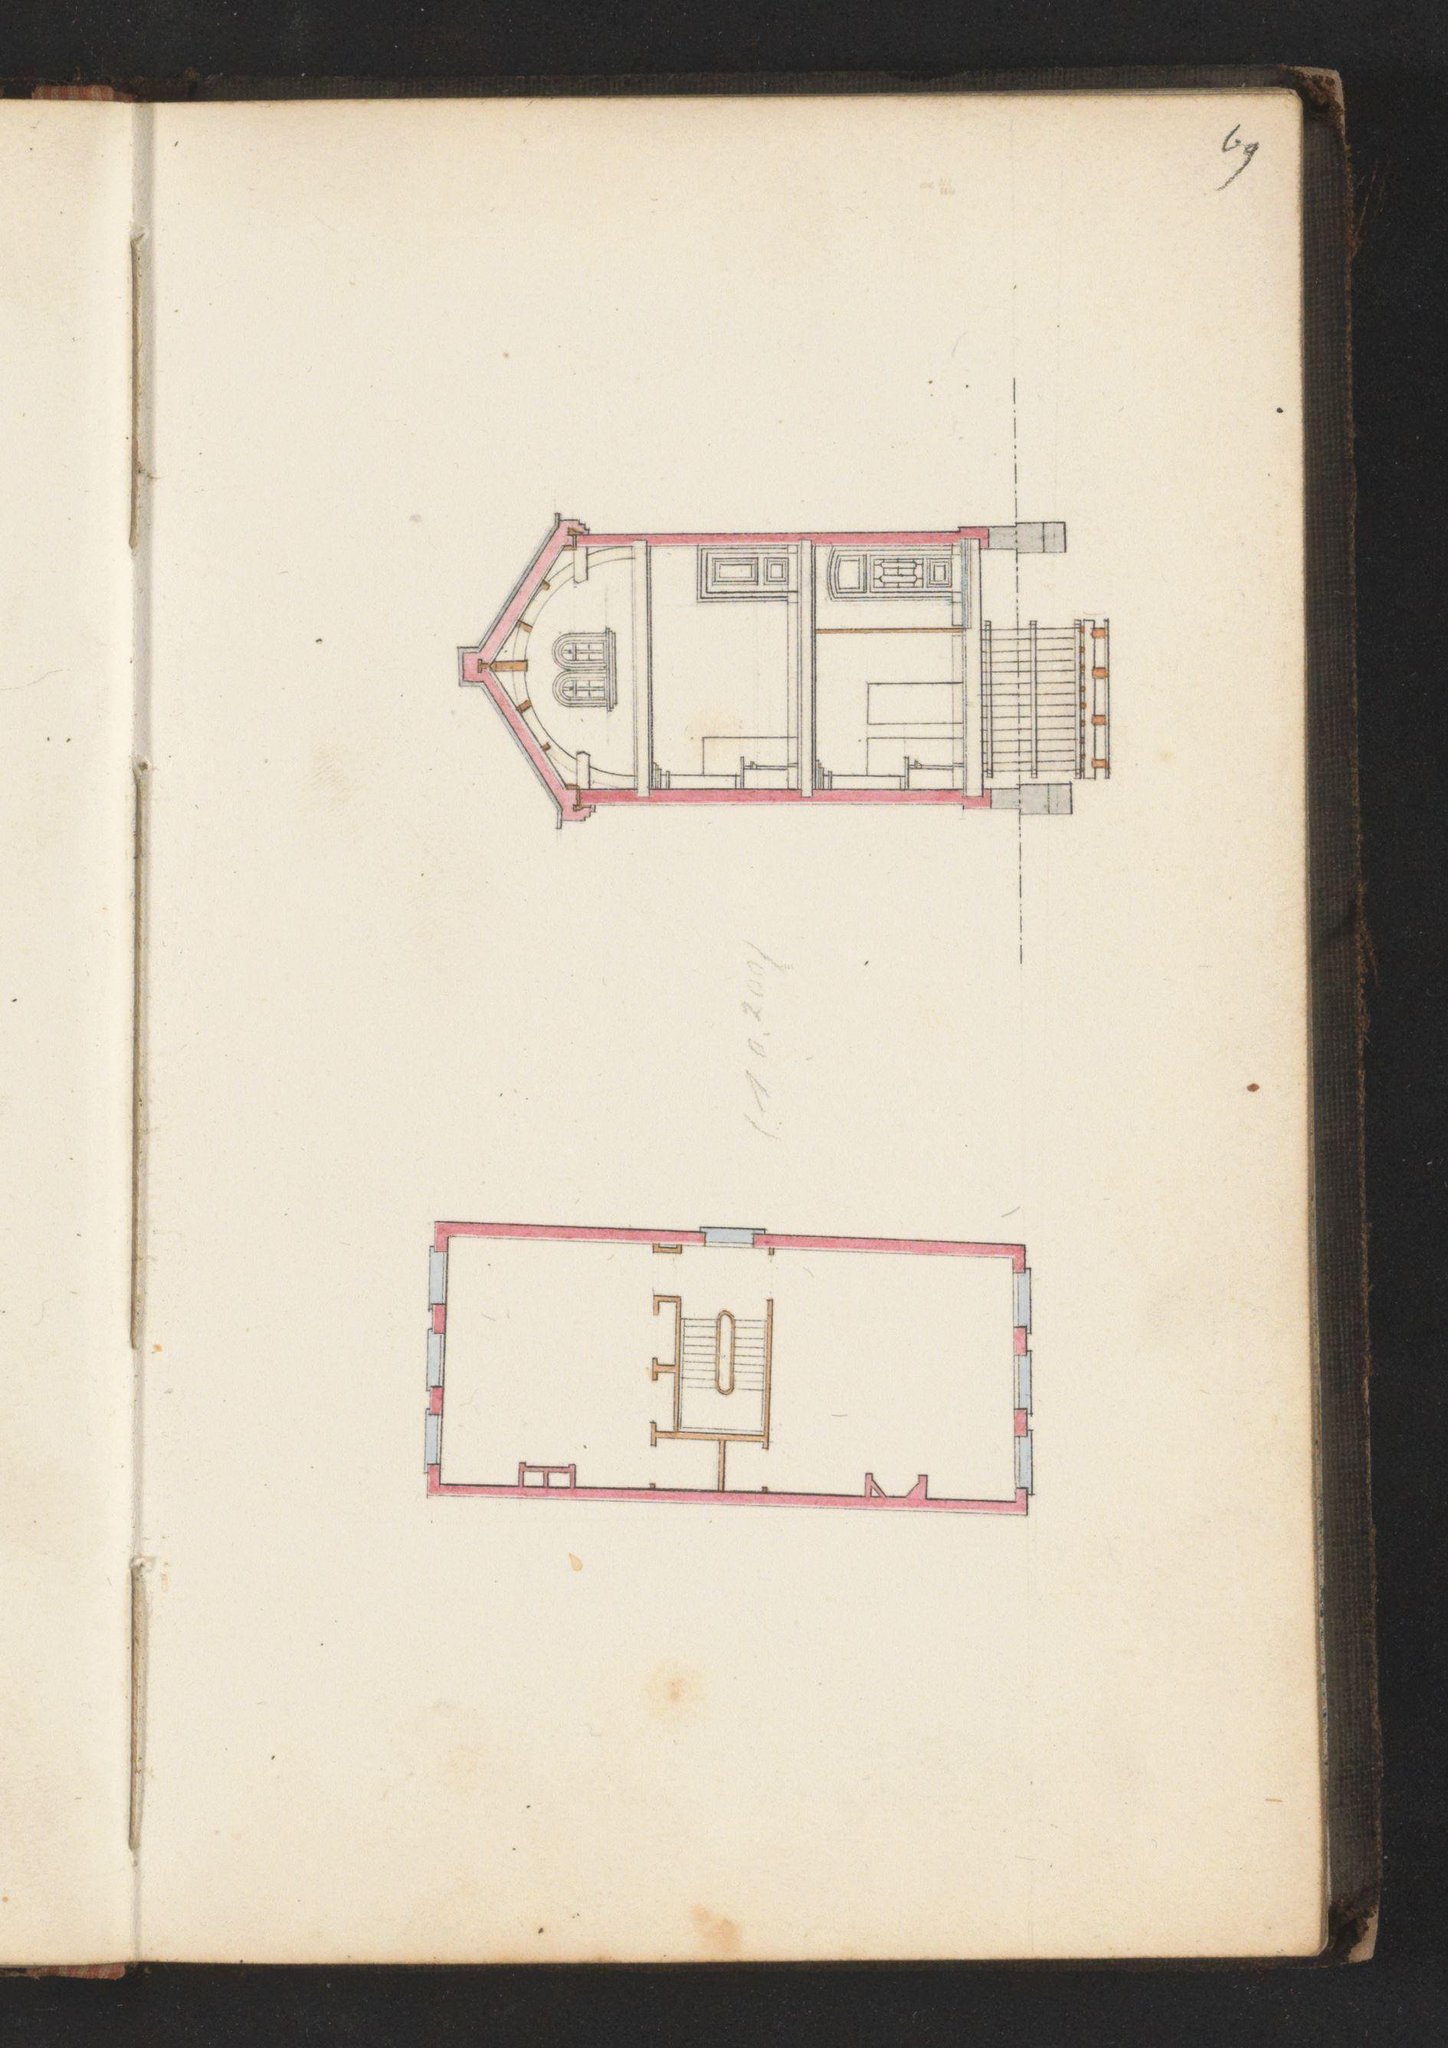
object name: sketchbook leaf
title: Doorsnede en een verdieping van een pand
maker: willem springer jr.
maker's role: draughtsman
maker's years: 1815-1907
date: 1864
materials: ink, paper, pencil, watercolor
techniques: brush, pen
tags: plan ~ architecture, section ~ architectural design or model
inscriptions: annotation: ‘([...] 0200)’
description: Pagina 69 uit een schetsboek met 164 pagina's.